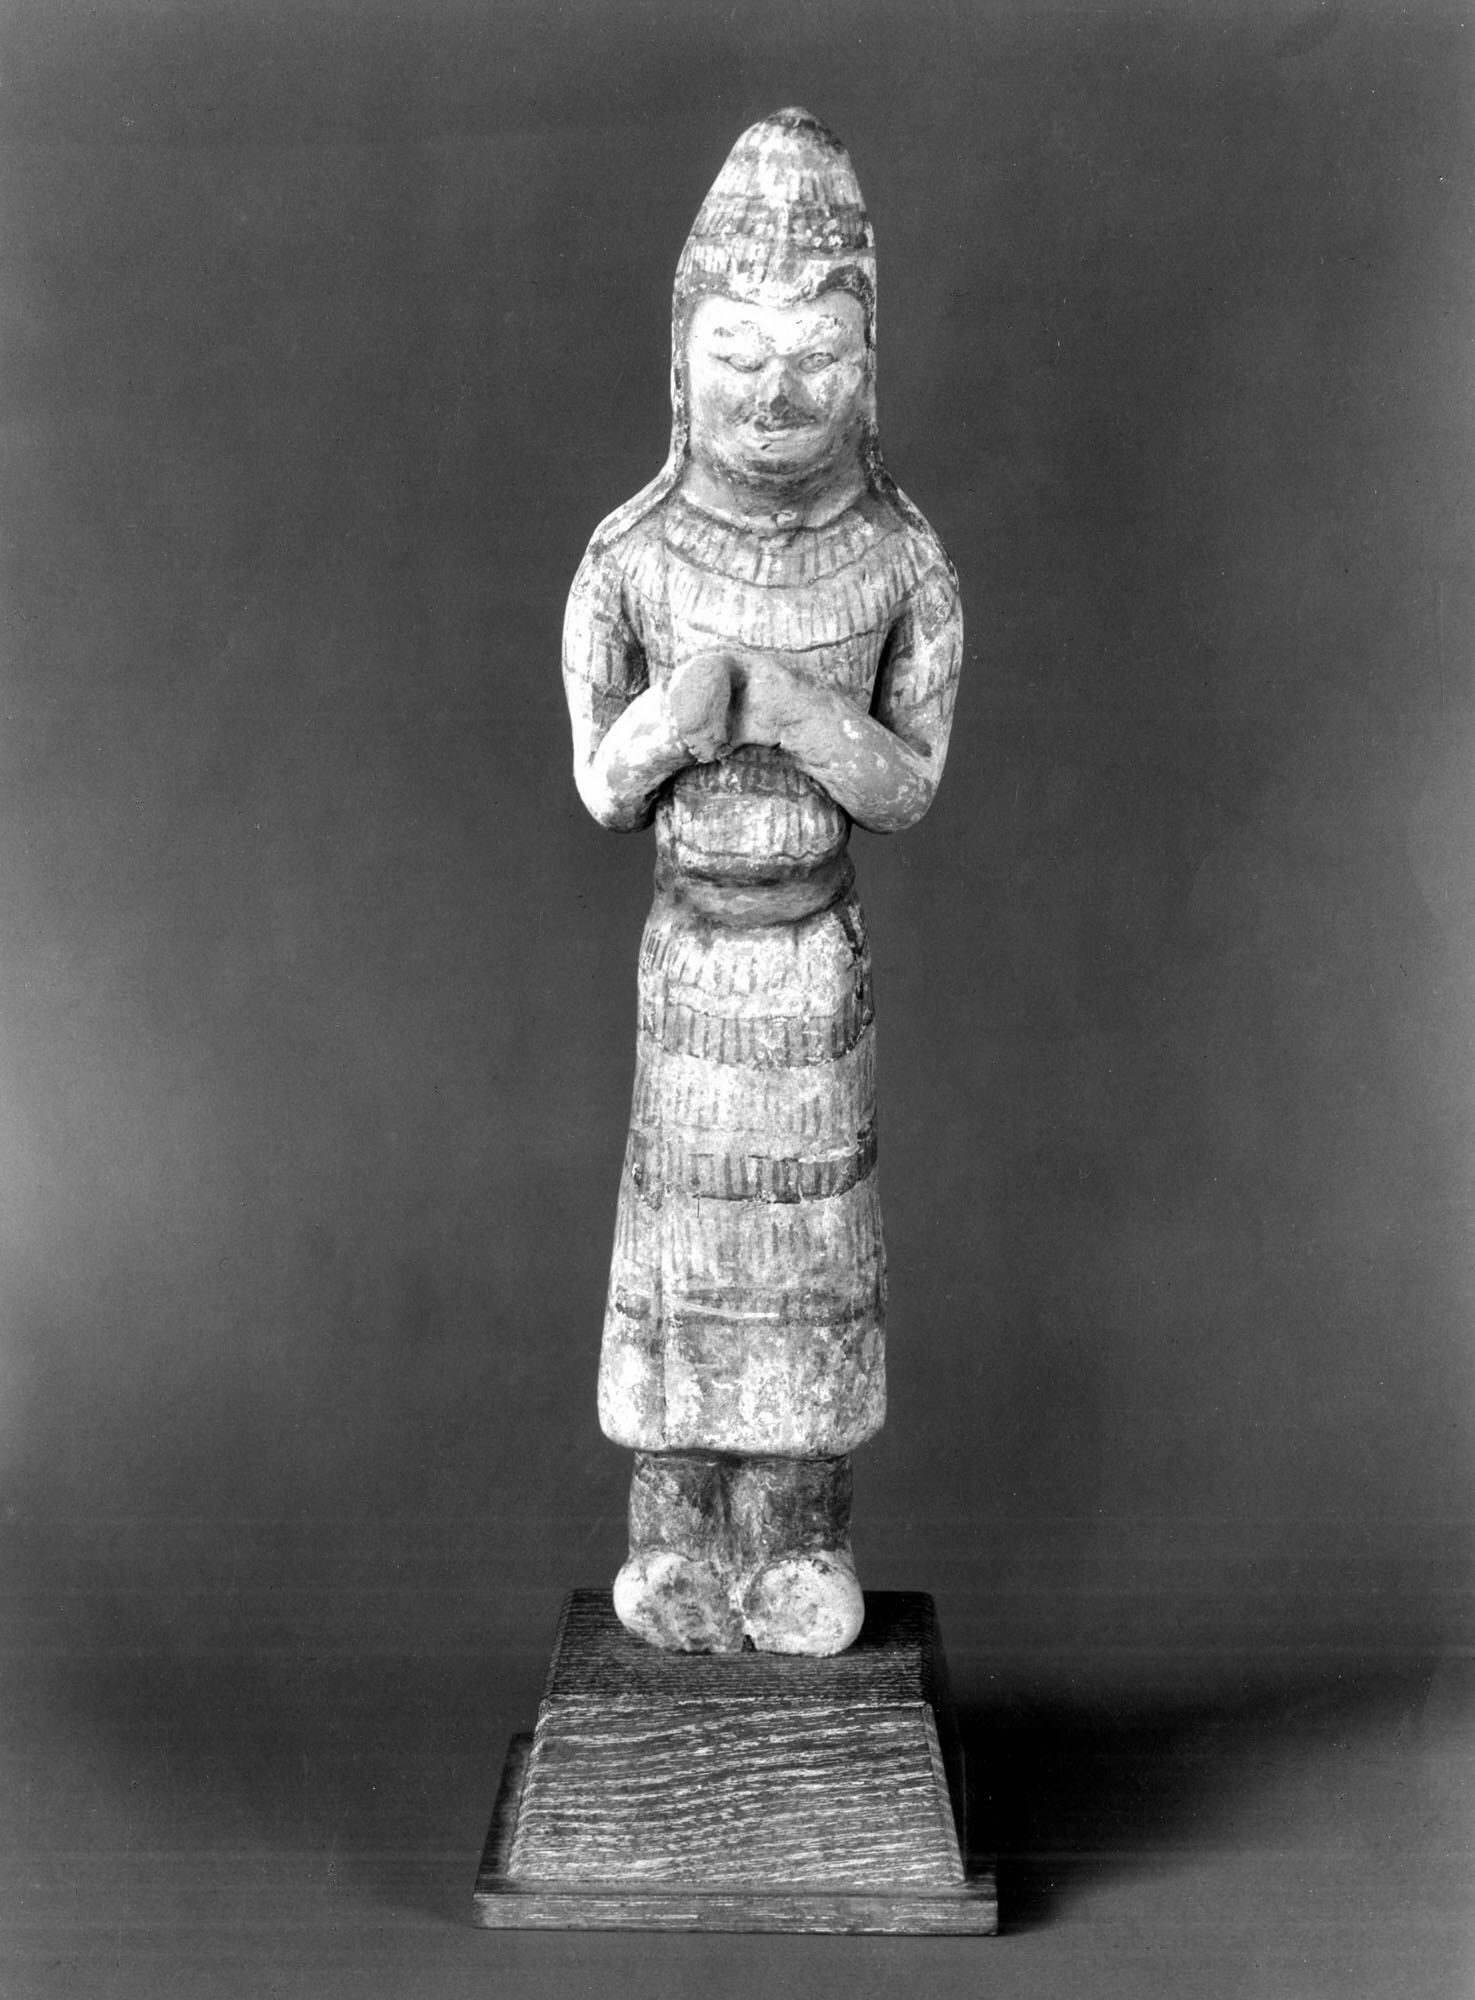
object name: figure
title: Warrior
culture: chinese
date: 601-700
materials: clay, pigment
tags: soldiers